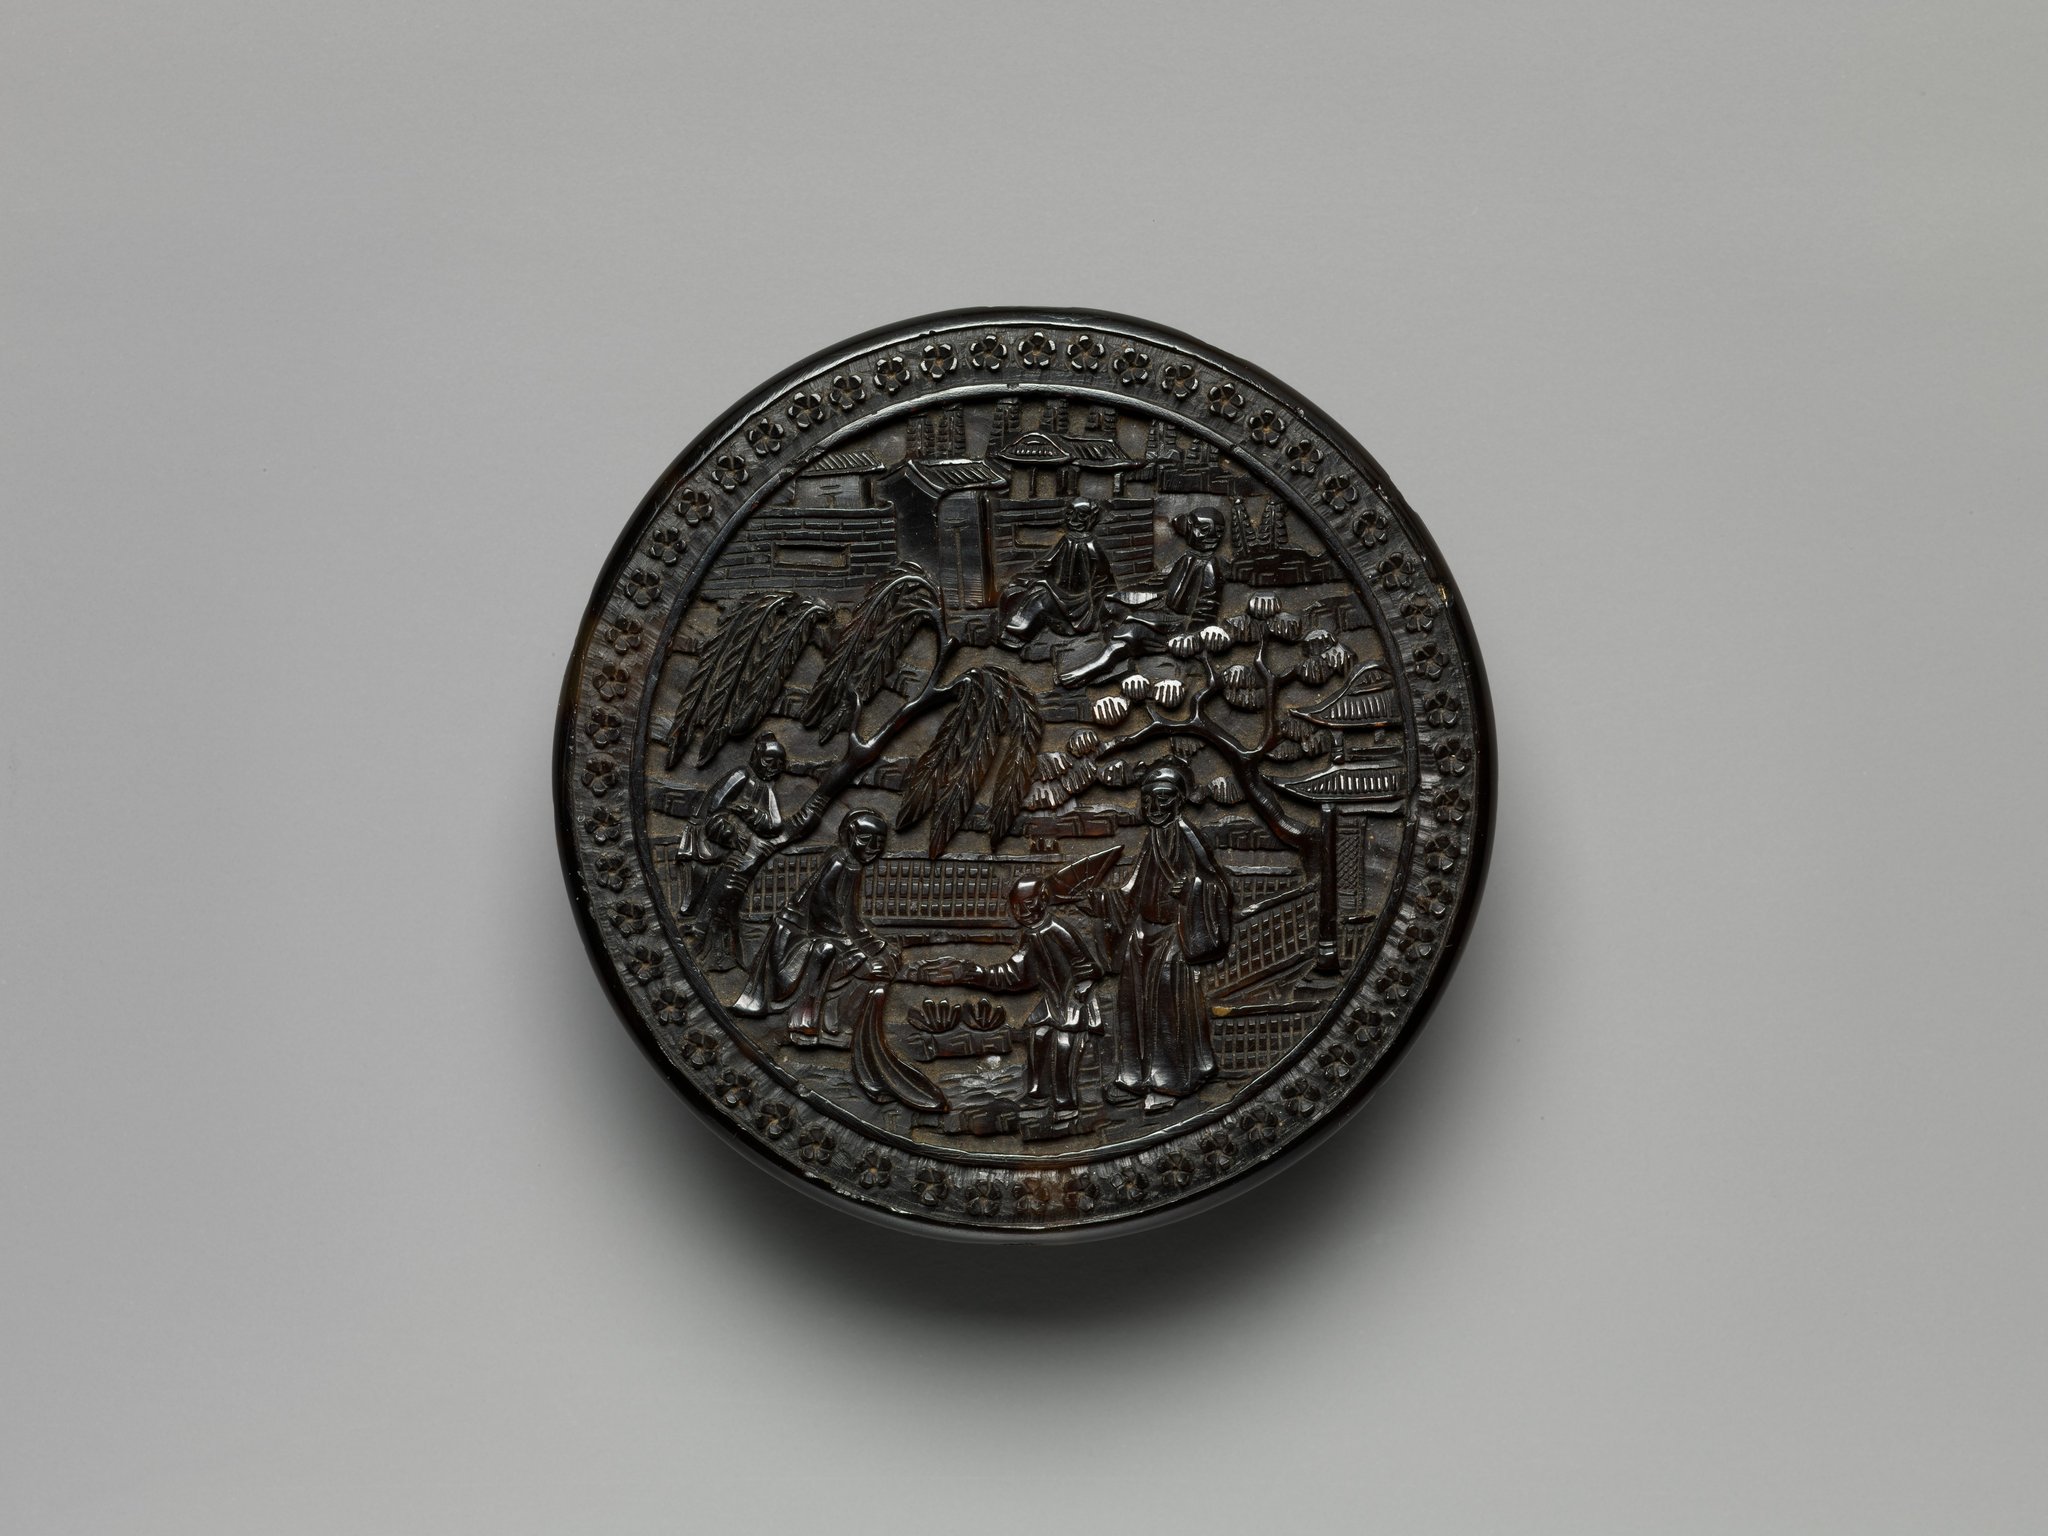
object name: box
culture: chinese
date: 1701-1800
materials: shell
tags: human figures,trees